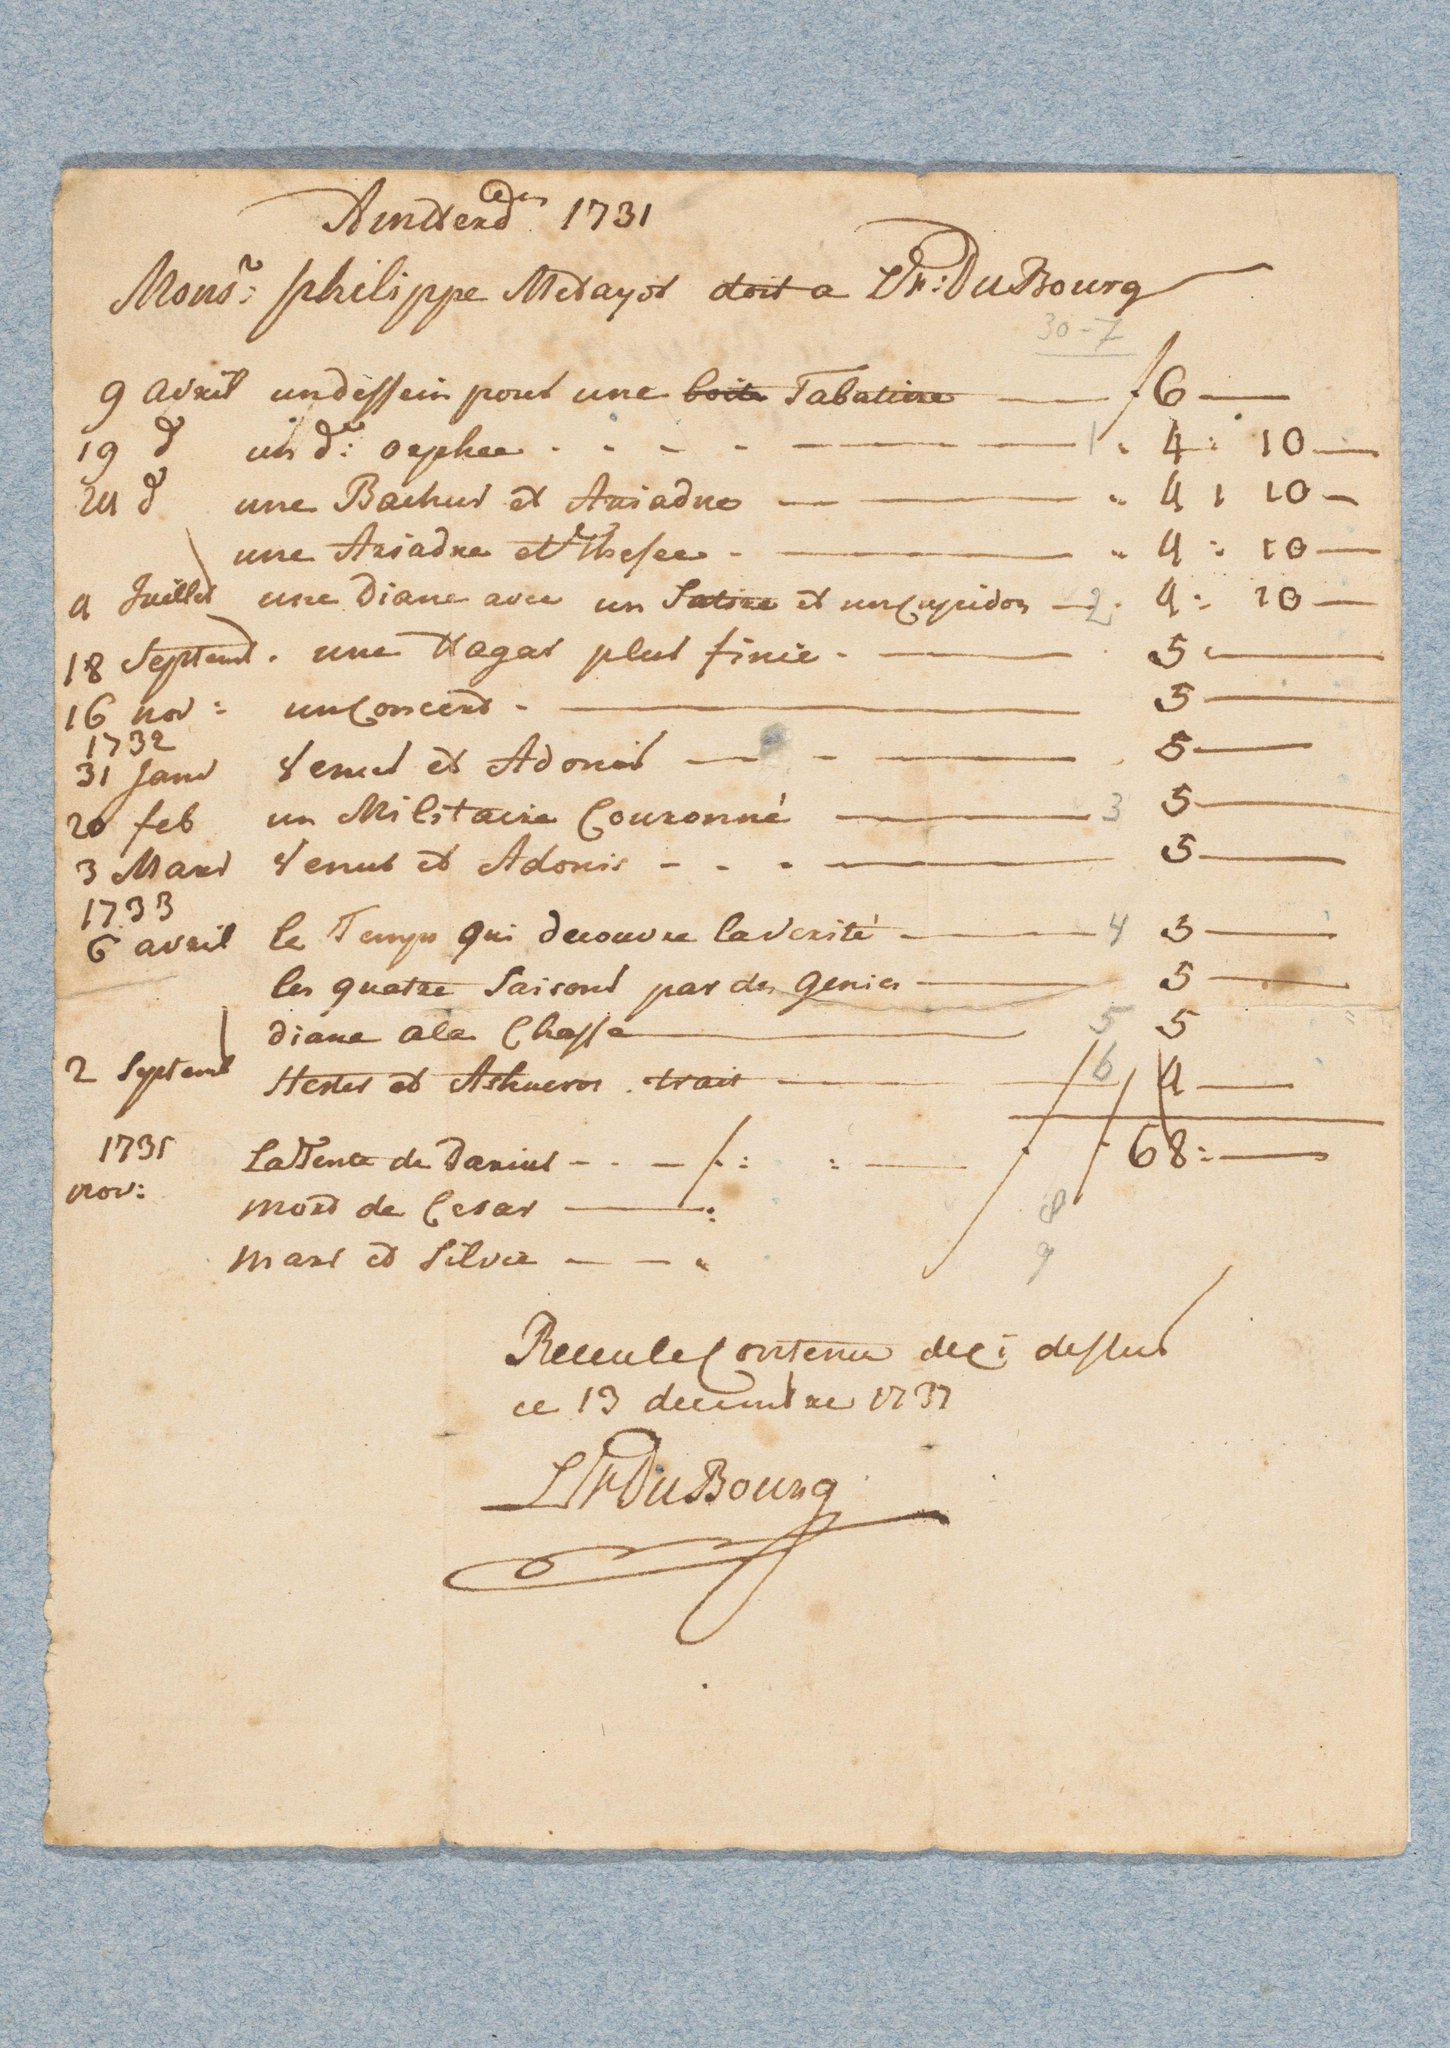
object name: account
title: Rekening van Dubourg aan Philippe Metayer, 1731, betaald 13 december 1737 (in doos met 43 tekeningen)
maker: louis fabritius dubourg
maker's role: draughtsman, print maker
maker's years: 1693-1775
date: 1737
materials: paper, pencil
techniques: pen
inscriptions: date